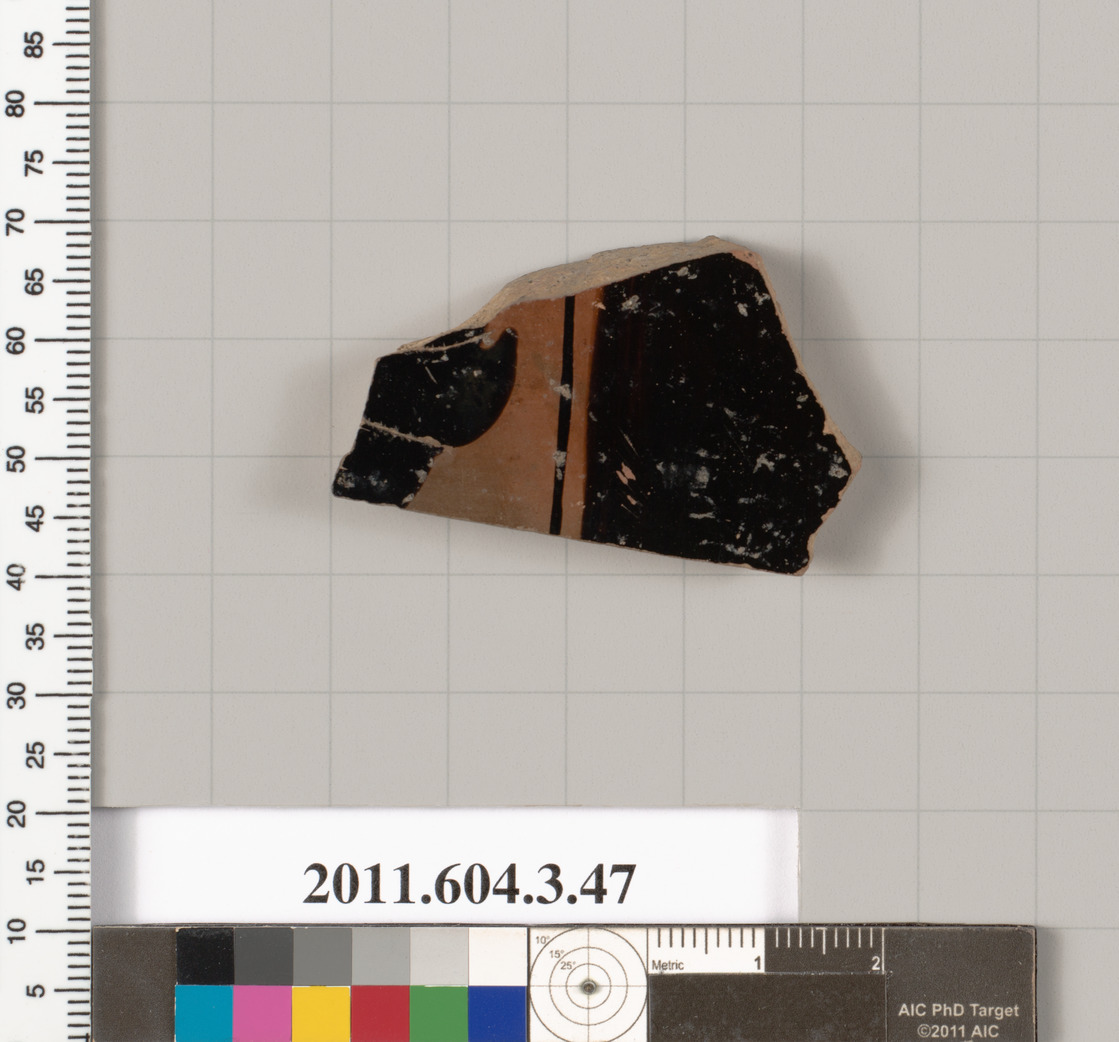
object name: amphora fragment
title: Terracotta fragment of an amphora (jar)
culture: greek, attic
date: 520 BCE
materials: terracotta